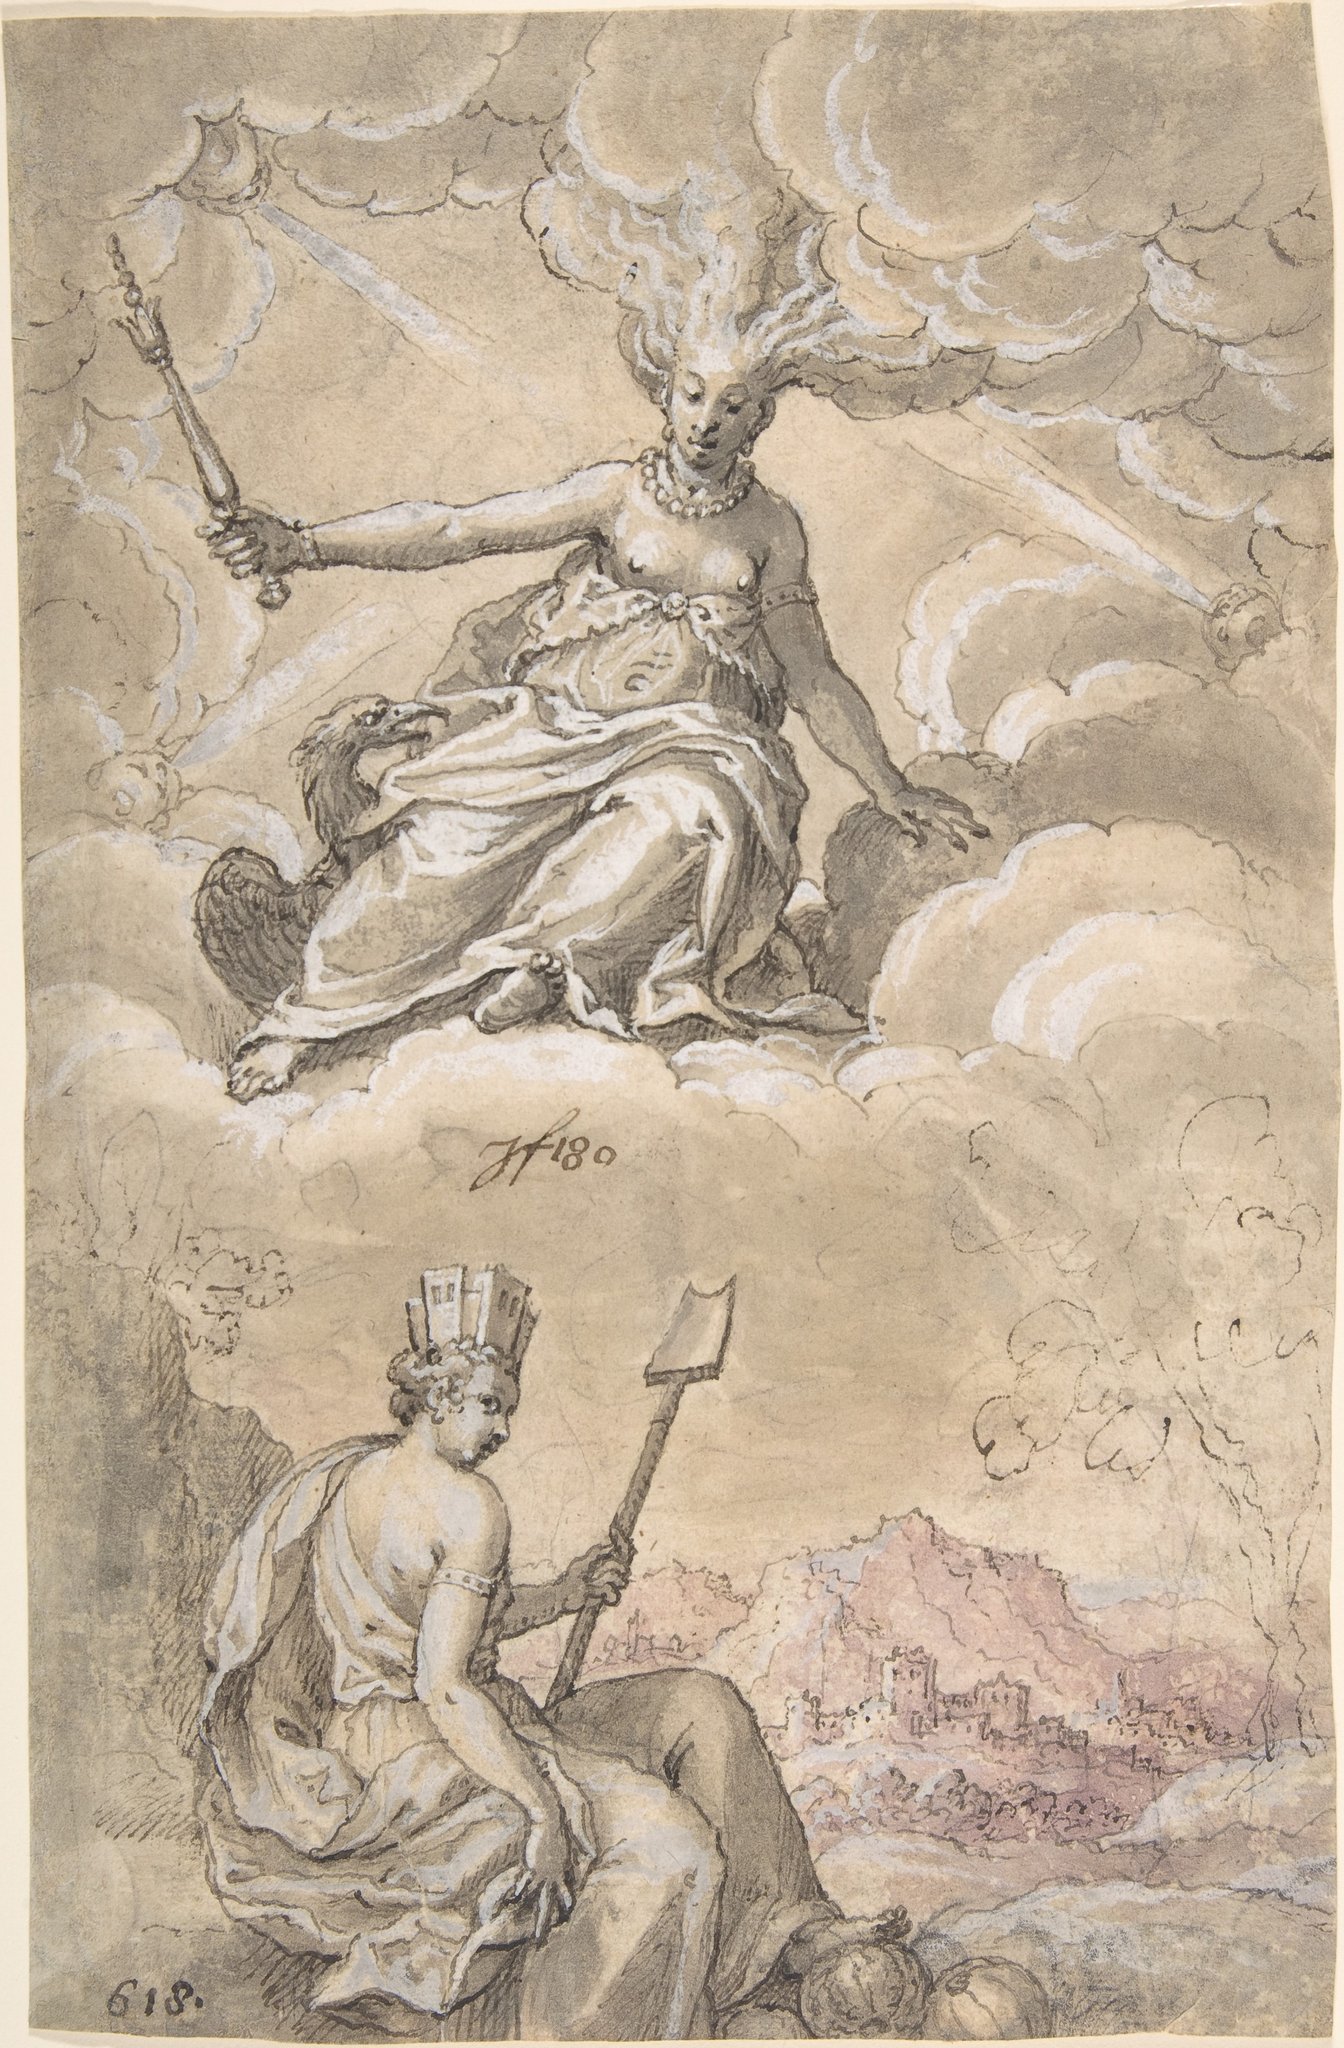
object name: drawing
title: Allegory of Air and Earth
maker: bartholomäus reiter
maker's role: artist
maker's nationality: german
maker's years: 1583-1622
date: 1618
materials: chalk, graphite, ink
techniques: heightening, pen, wash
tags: female nudes,allegory